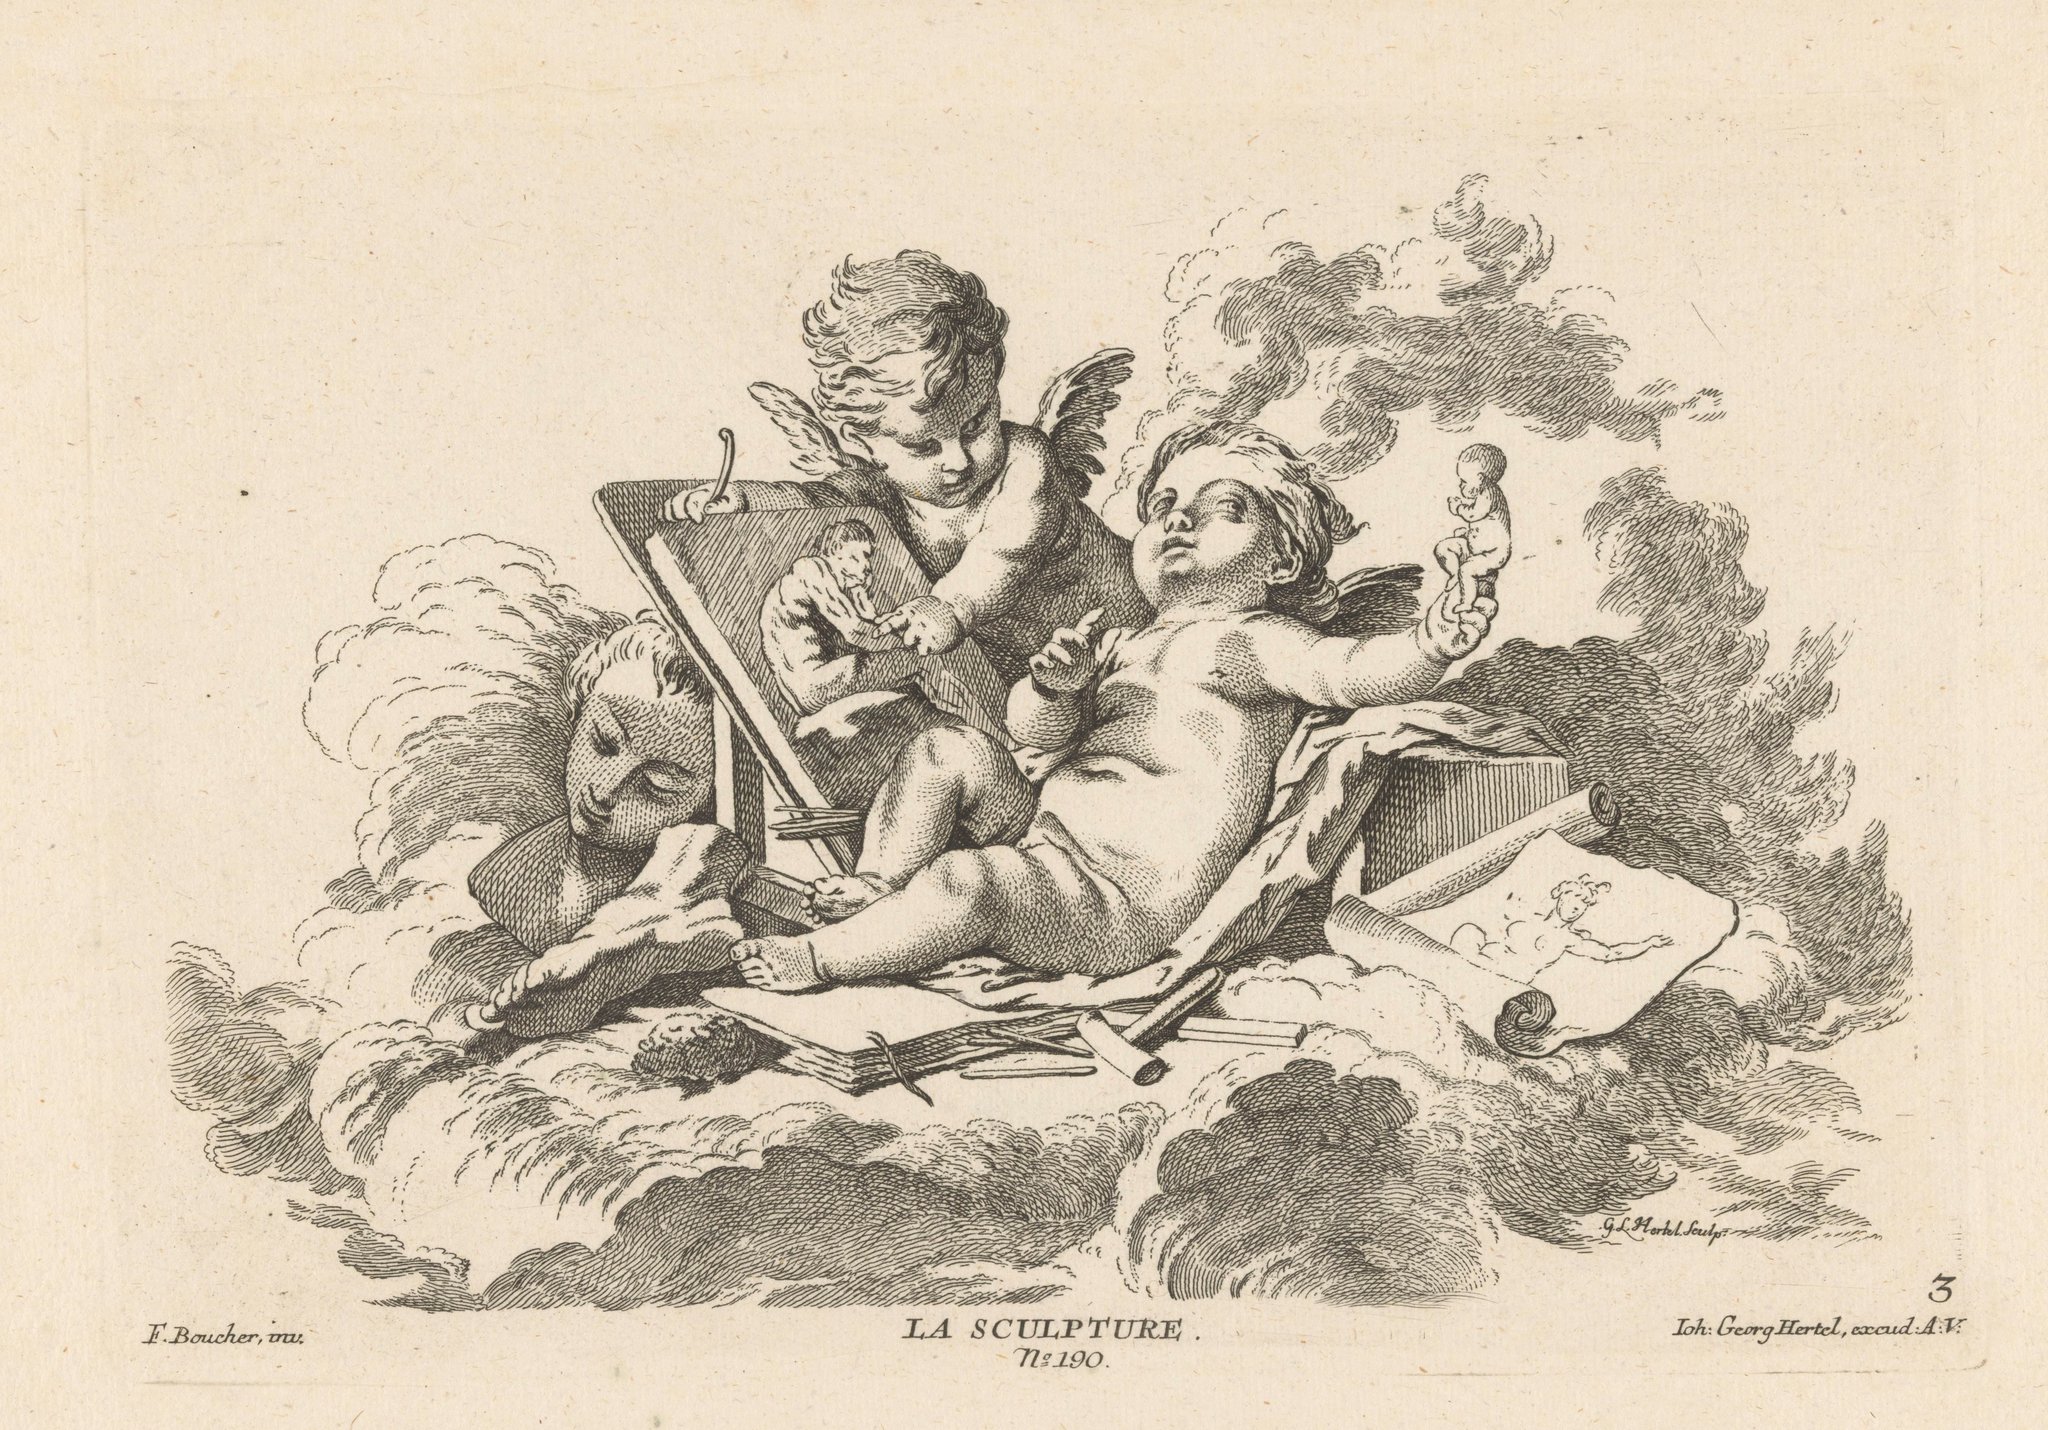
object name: ornament print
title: Livre des Arts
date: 1750-1778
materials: paper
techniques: engraving, etching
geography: augsburg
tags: 'sculptura', symbolic representations, allegories and emblems ~ sculpture; 'scoltura' (ripa), cupids: 'amores', 'amoretti', 'putti'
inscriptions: collector's mark: Lugt 2228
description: Allegorie van de beeldhouwkunst. Twee putti met attributen behorende bij beeldhouwkunst, zoals ontwerptekeningen, een klein model en delen van sculpturen. Uitgeversnummer 190.